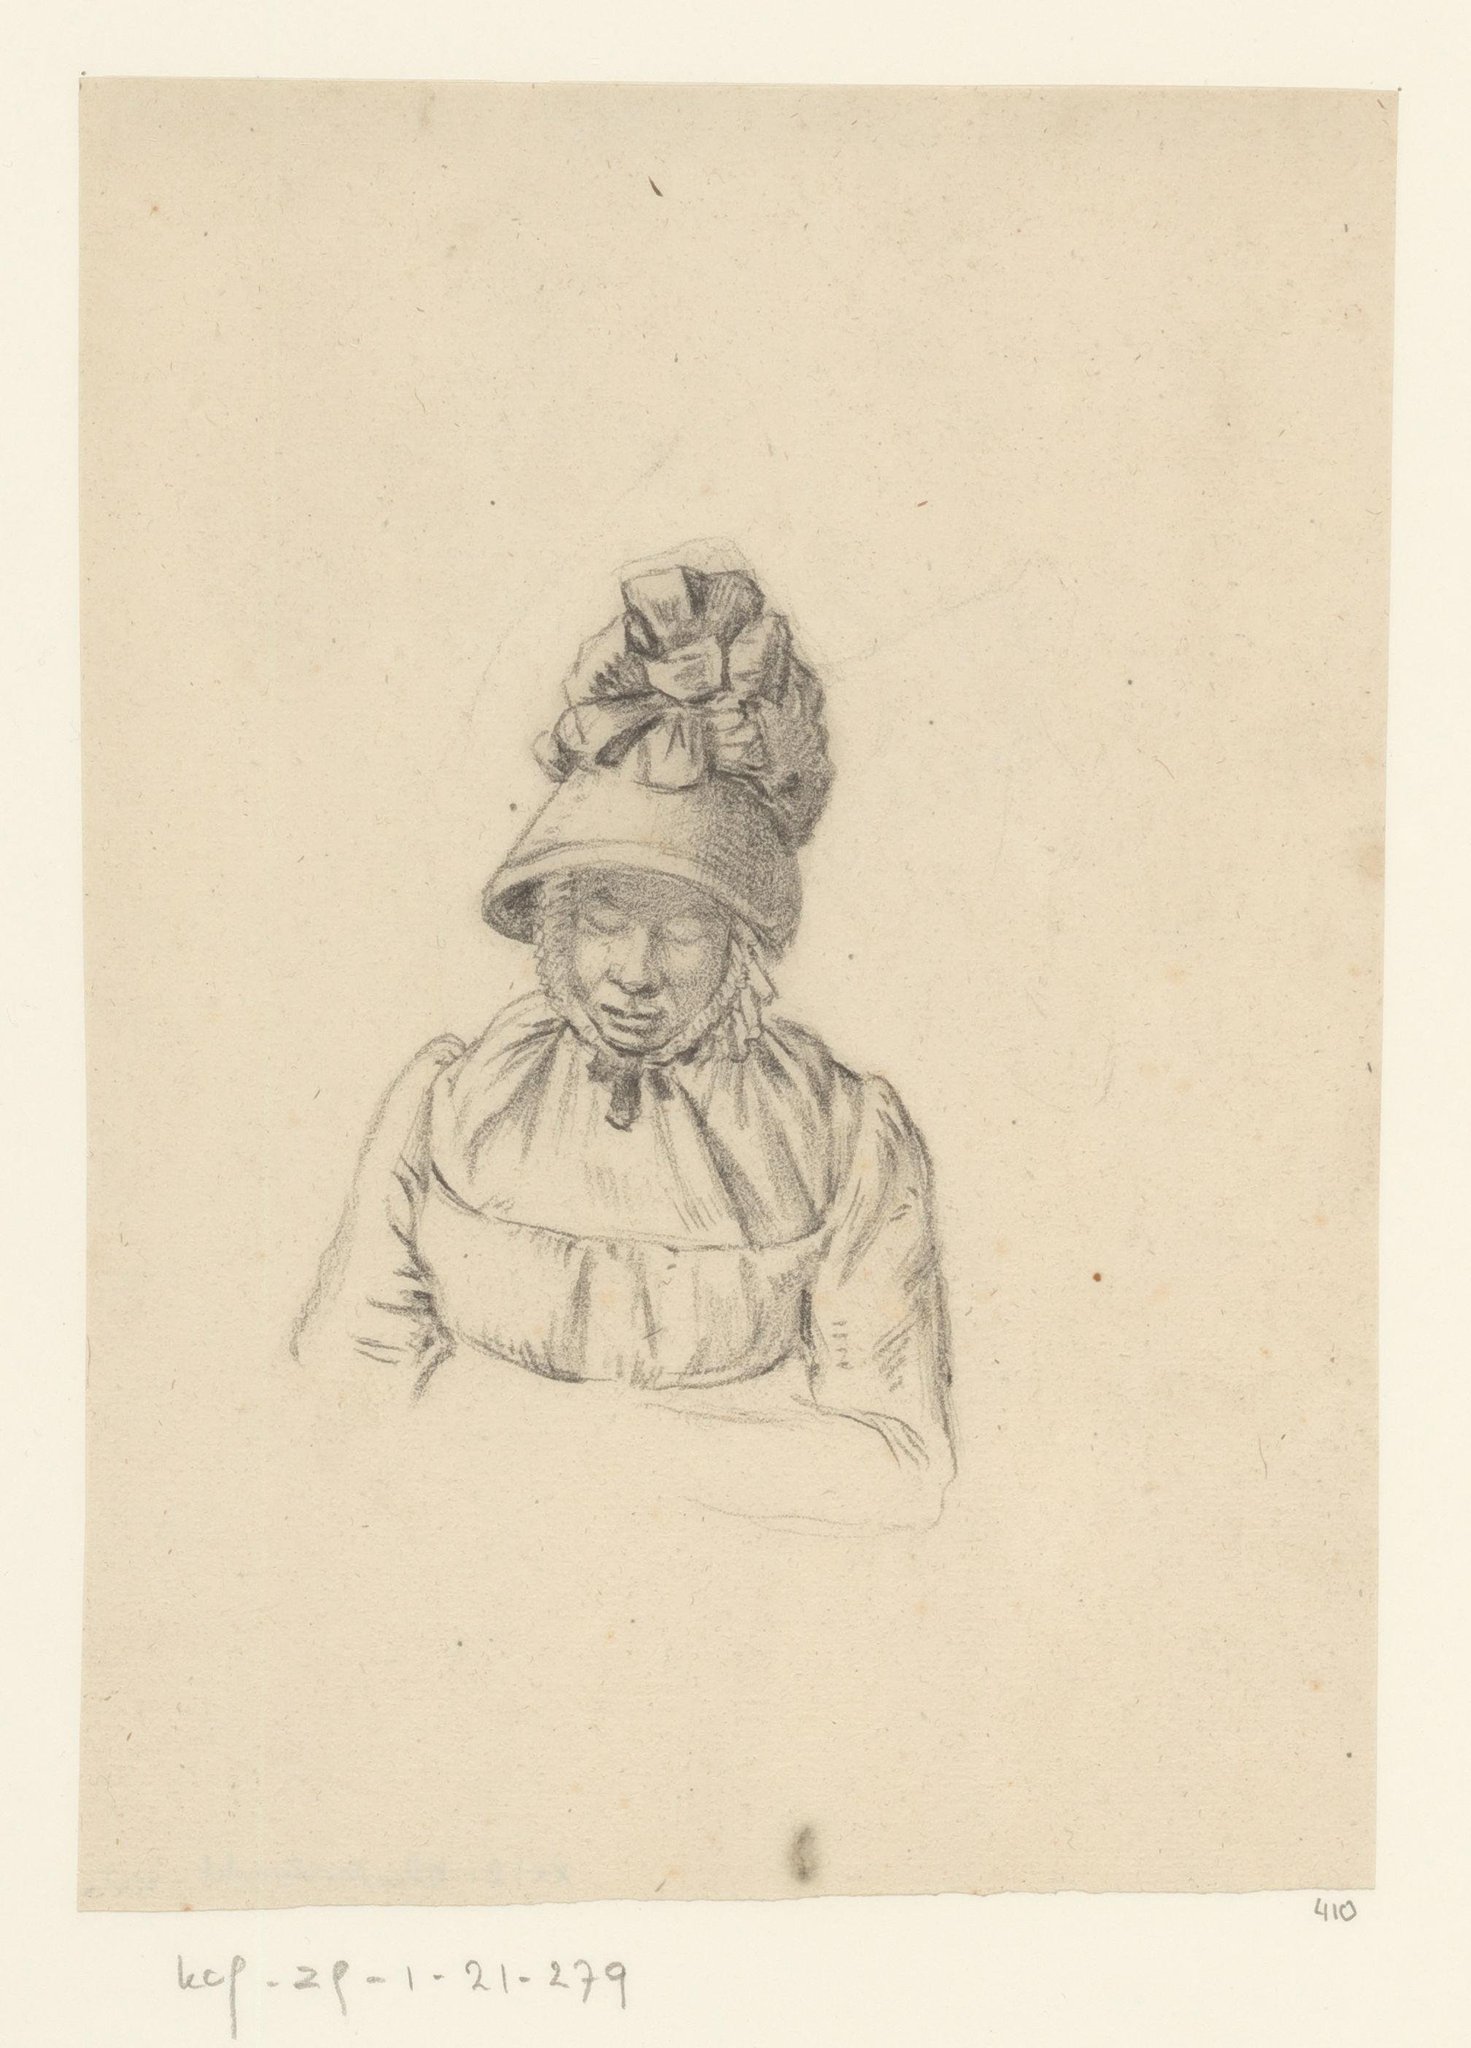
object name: drawing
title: Slapende vrouw met hoge muts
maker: jean bernard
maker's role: draughtsman, print maker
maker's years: 1765-1833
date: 1775-1833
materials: chalk, paper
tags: old woman, head-gear: cap, sleeping; unconsciousness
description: Onderwerpsrubrieken binnen de Atlas Zeden en Gewoonten: Zeden en Gewoonten in Engeren Zin, De Kleeding, Kleederdrachten (tijdvakken), De regeering van Willem I. Mannen en vrouwen.